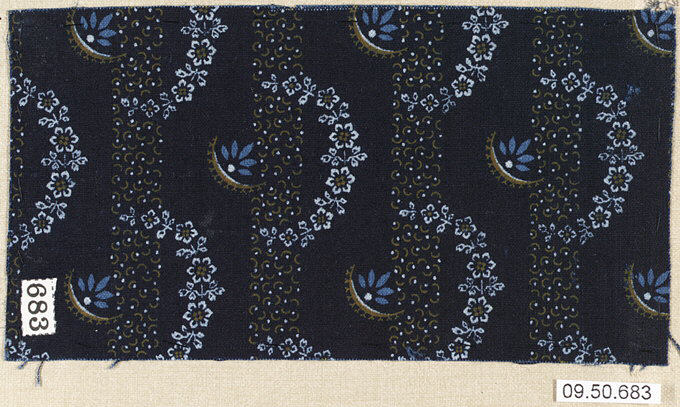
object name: piece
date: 1801-1900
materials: cotton